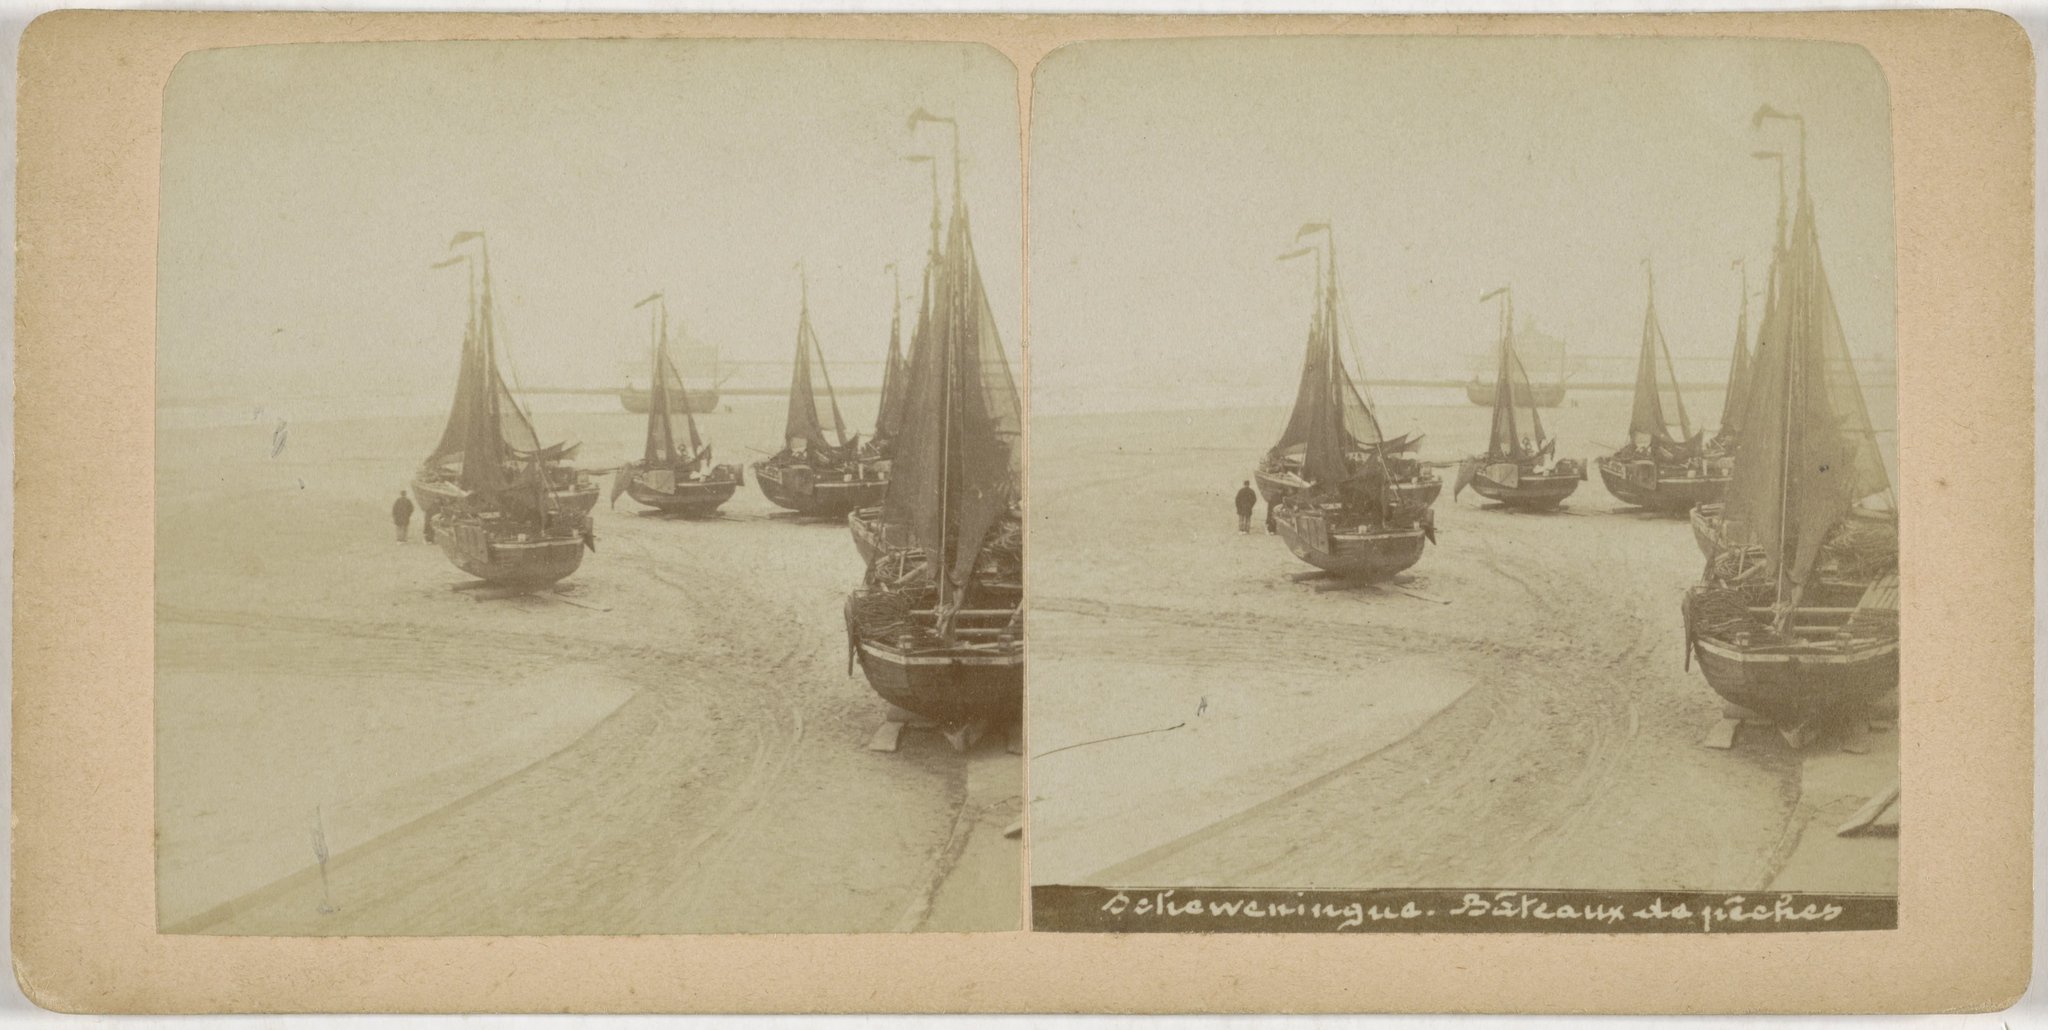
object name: stereograph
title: Vissersboten op het strand van Scheveningen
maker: Anonymous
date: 1873-1890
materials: cardboard, paper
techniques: albumen print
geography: scheveningen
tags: ships, boats on land, beached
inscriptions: inscription: ‘12 1/2’